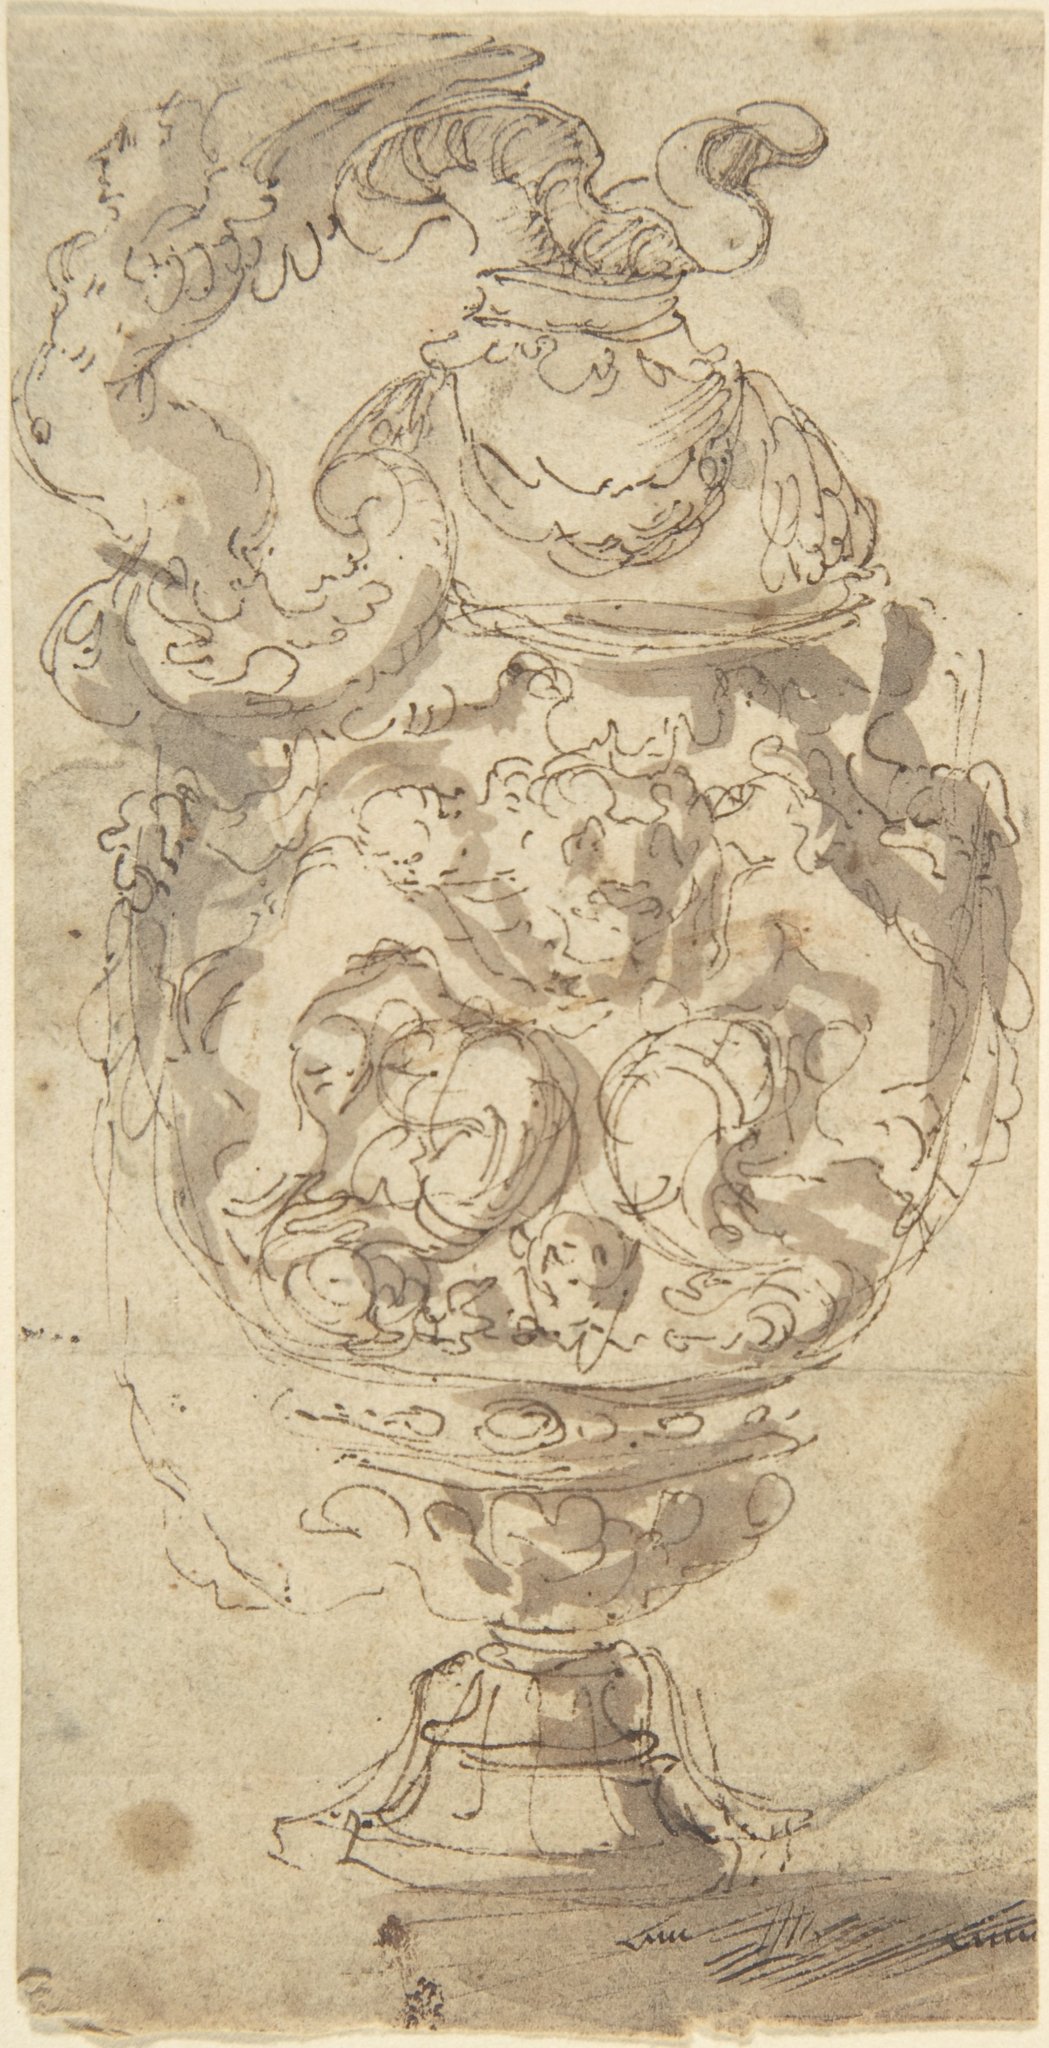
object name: drawing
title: Design for a Jug with Winged-figure Handle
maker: anonymous, italian?, 16th century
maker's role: artist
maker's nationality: italian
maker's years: 1500-1600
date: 1550-1600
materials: chalk, ink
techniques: brush, pen, wash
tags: jugs